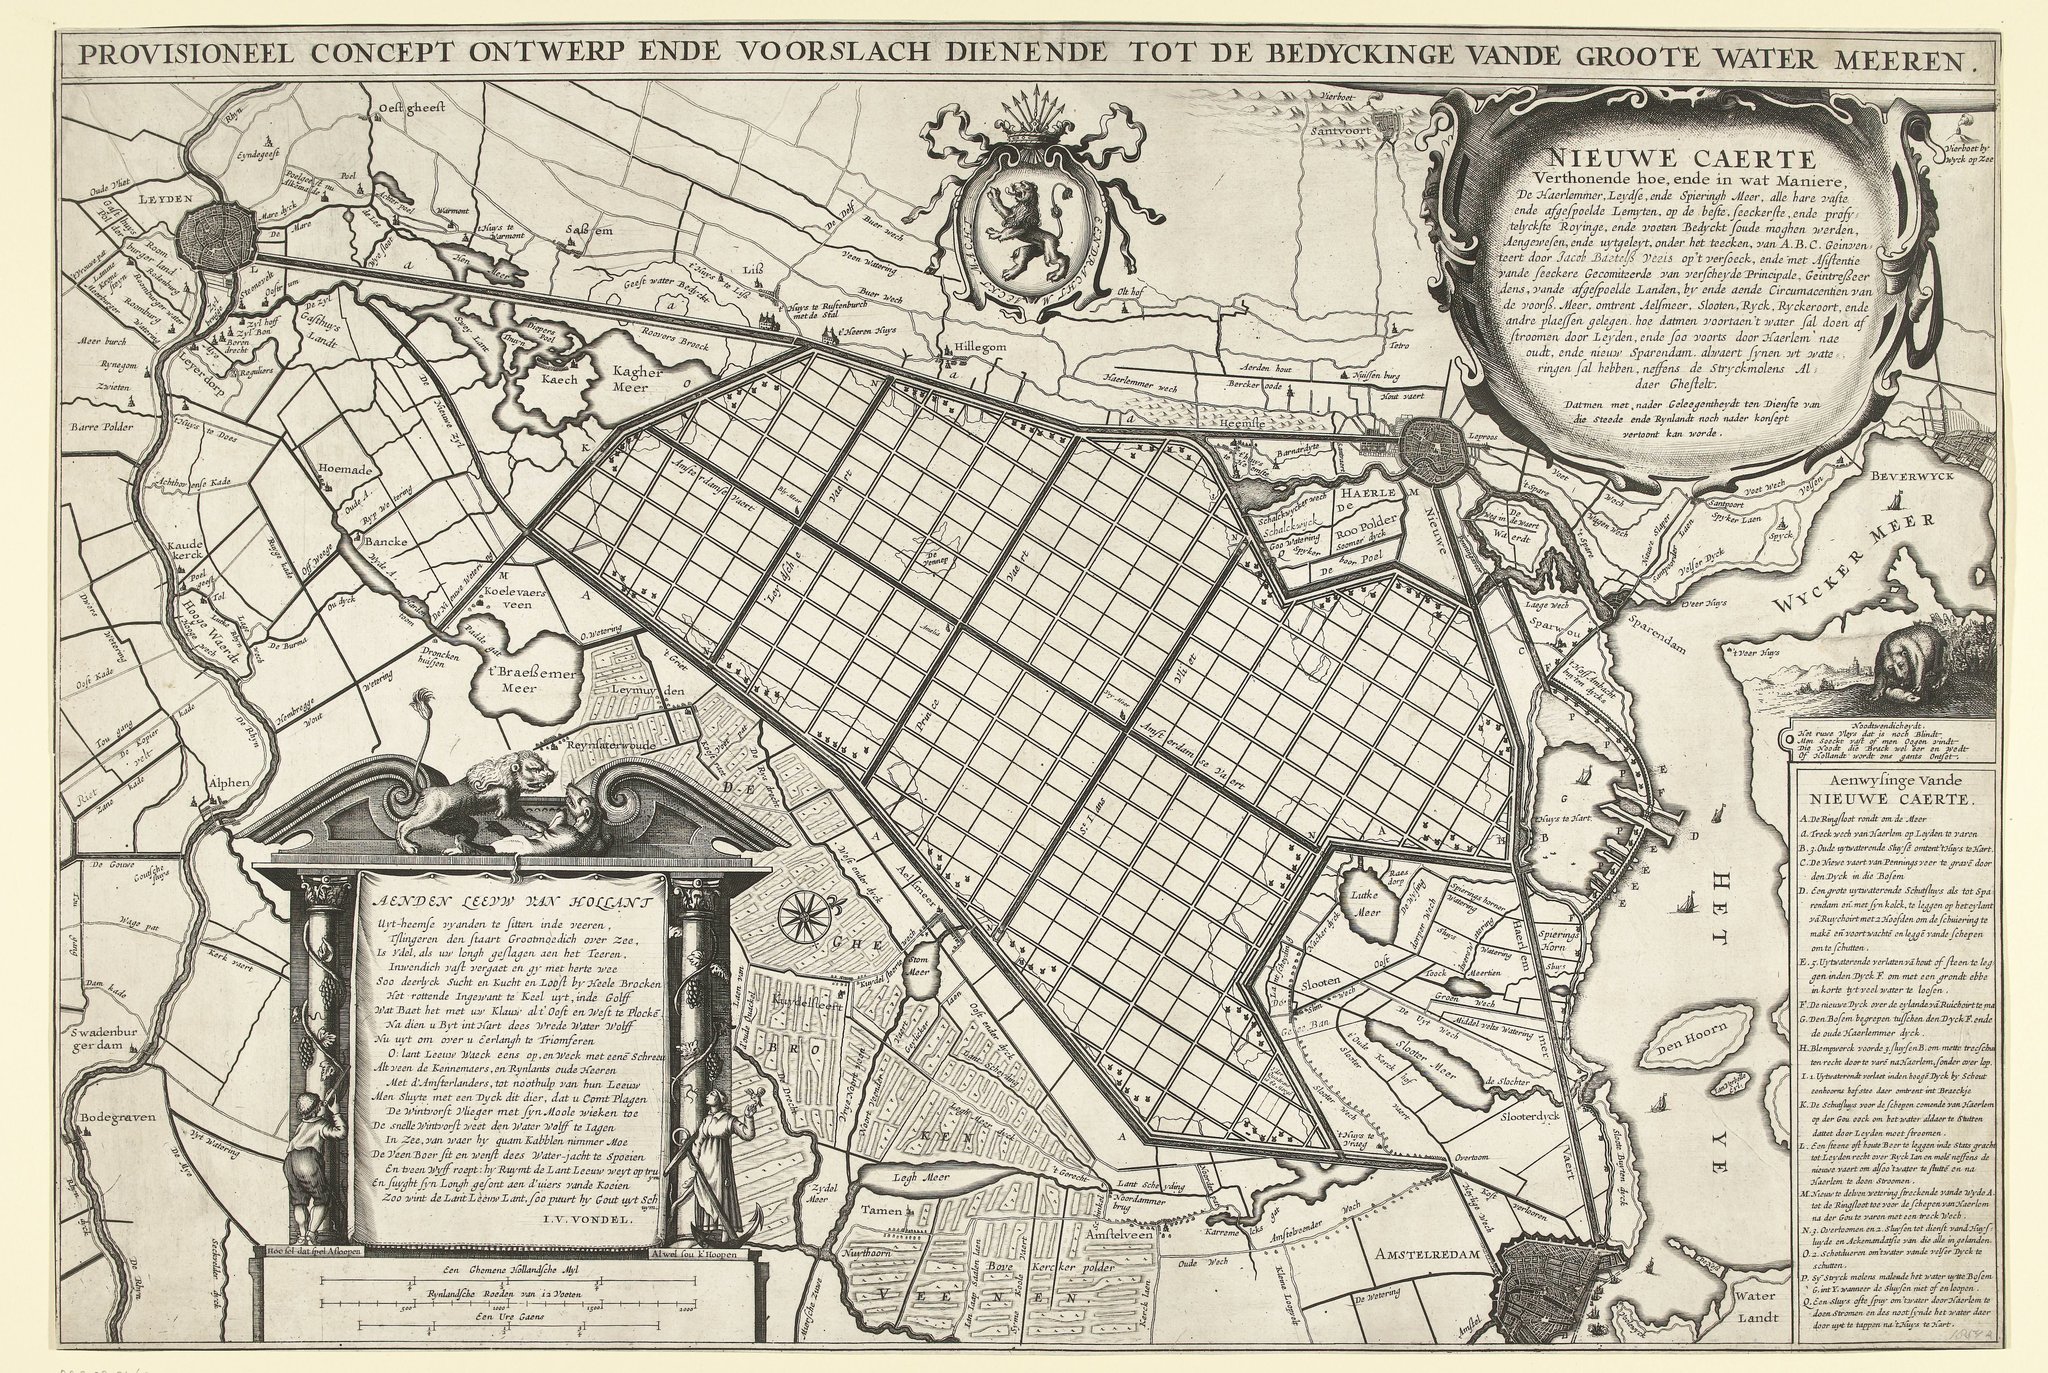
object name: print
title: Provisioneel concept ontwerp ende voorslach dienende tot de bedyckinge vande groote water meeren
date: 1641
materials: paper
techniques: engraving, etching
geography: northern netherlands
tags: coat of arms (as symbol of the state, etc.), maps of separate countries or regions, polder, reclaimed land, maps of cities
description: Kaart met een ontwerp voor de bedijking van de Haarlemmermeer, 1641. Links Leiden, rechts Haarlem, onderaan Amsterdam. Rechtsboven een cartouche met de titel. Linksonder een tussen zuilen een hangende doek met een vers getiteld: Aen den Leeuw van Hollant. Op het timpaan een leeuw die een wolf verslaat, onderaan de zuilen een landmeter en de personificatie van de Hoop. Rechts de legenda A-Q, hierboven een berin met een jong. In het midden bovenaan het wapen van de Staten-Generaal.